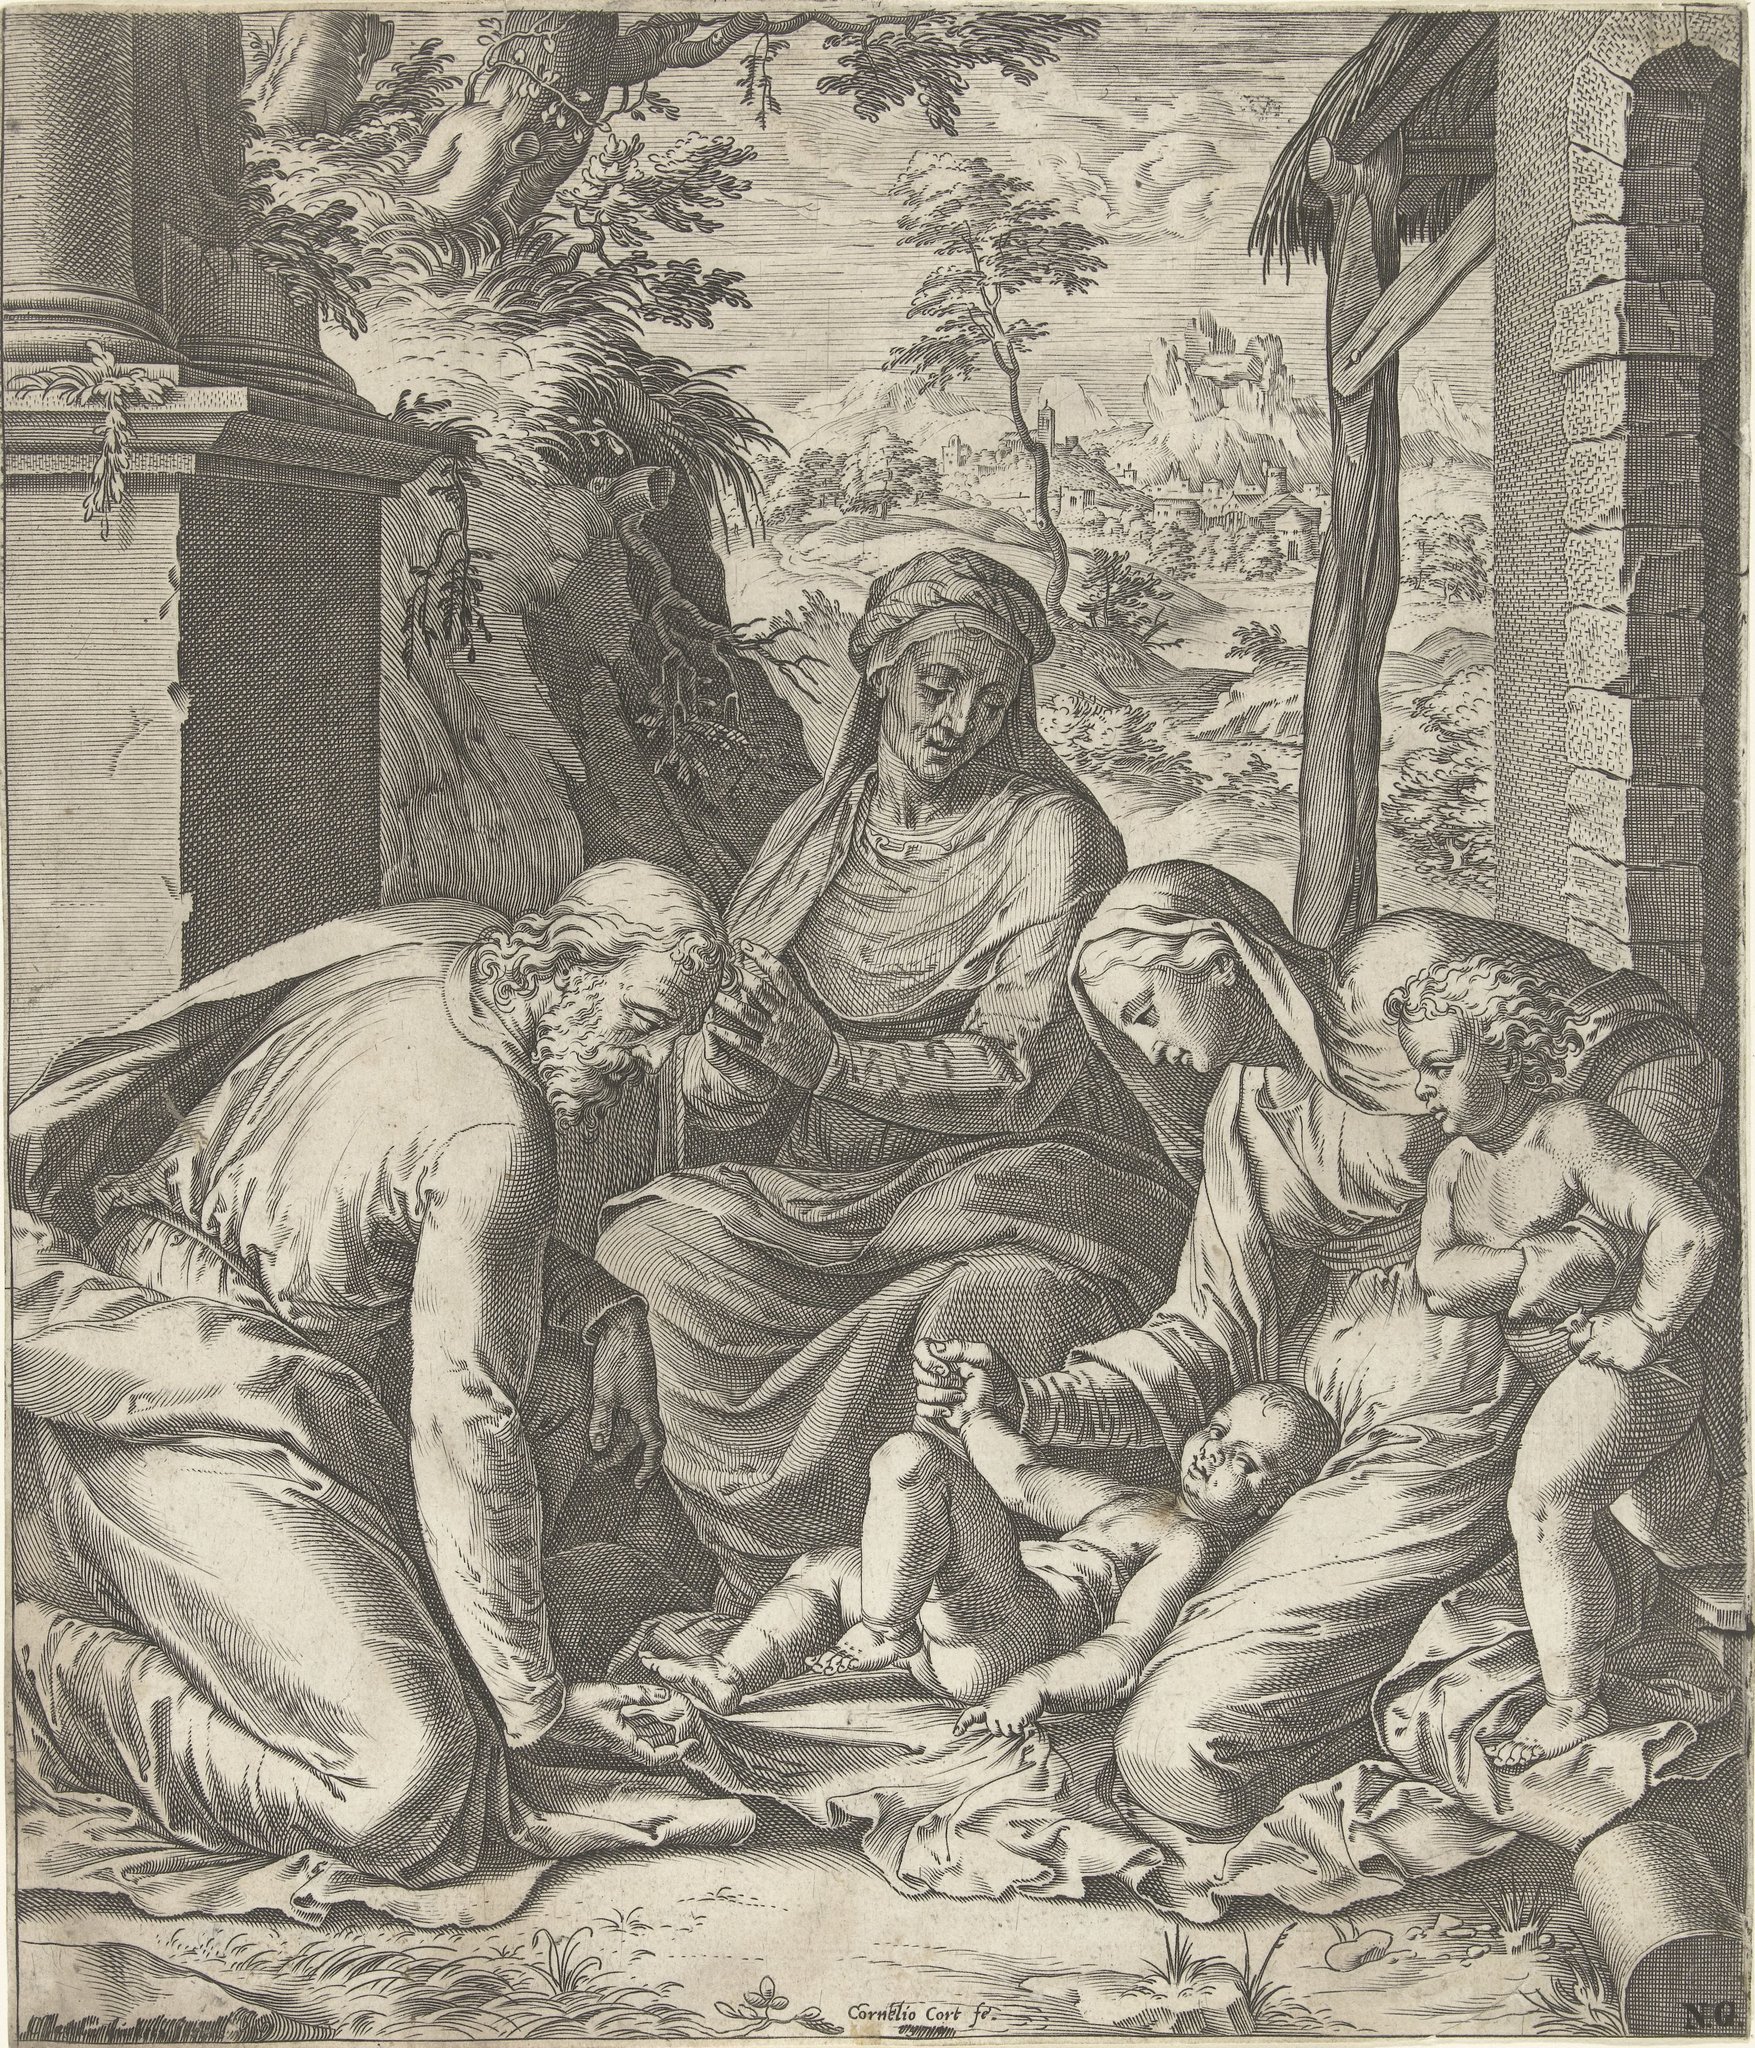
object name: print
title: Heilige Familie met Anna en Johannes de Doper als kind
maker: cornelis cort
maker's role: print maker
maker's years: 1533-1578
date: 1570-1577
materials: paper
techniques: engraving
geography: rome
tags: holy family with john the baptist (as child), holy family with others, e.g.: anna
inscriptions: signature: ‘Cornelio Cort fe.’, collector's mark: Lugt 1967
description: Maria en Jozef zitten op de grond voor de stal, het Kind ligt op een doek. Maria houdt Johannes de Doper in haar arm. Anna zit tussen Jozef en Maria en houdt haar handen gevouwen. Op de achtergrond een glooiend landschap.